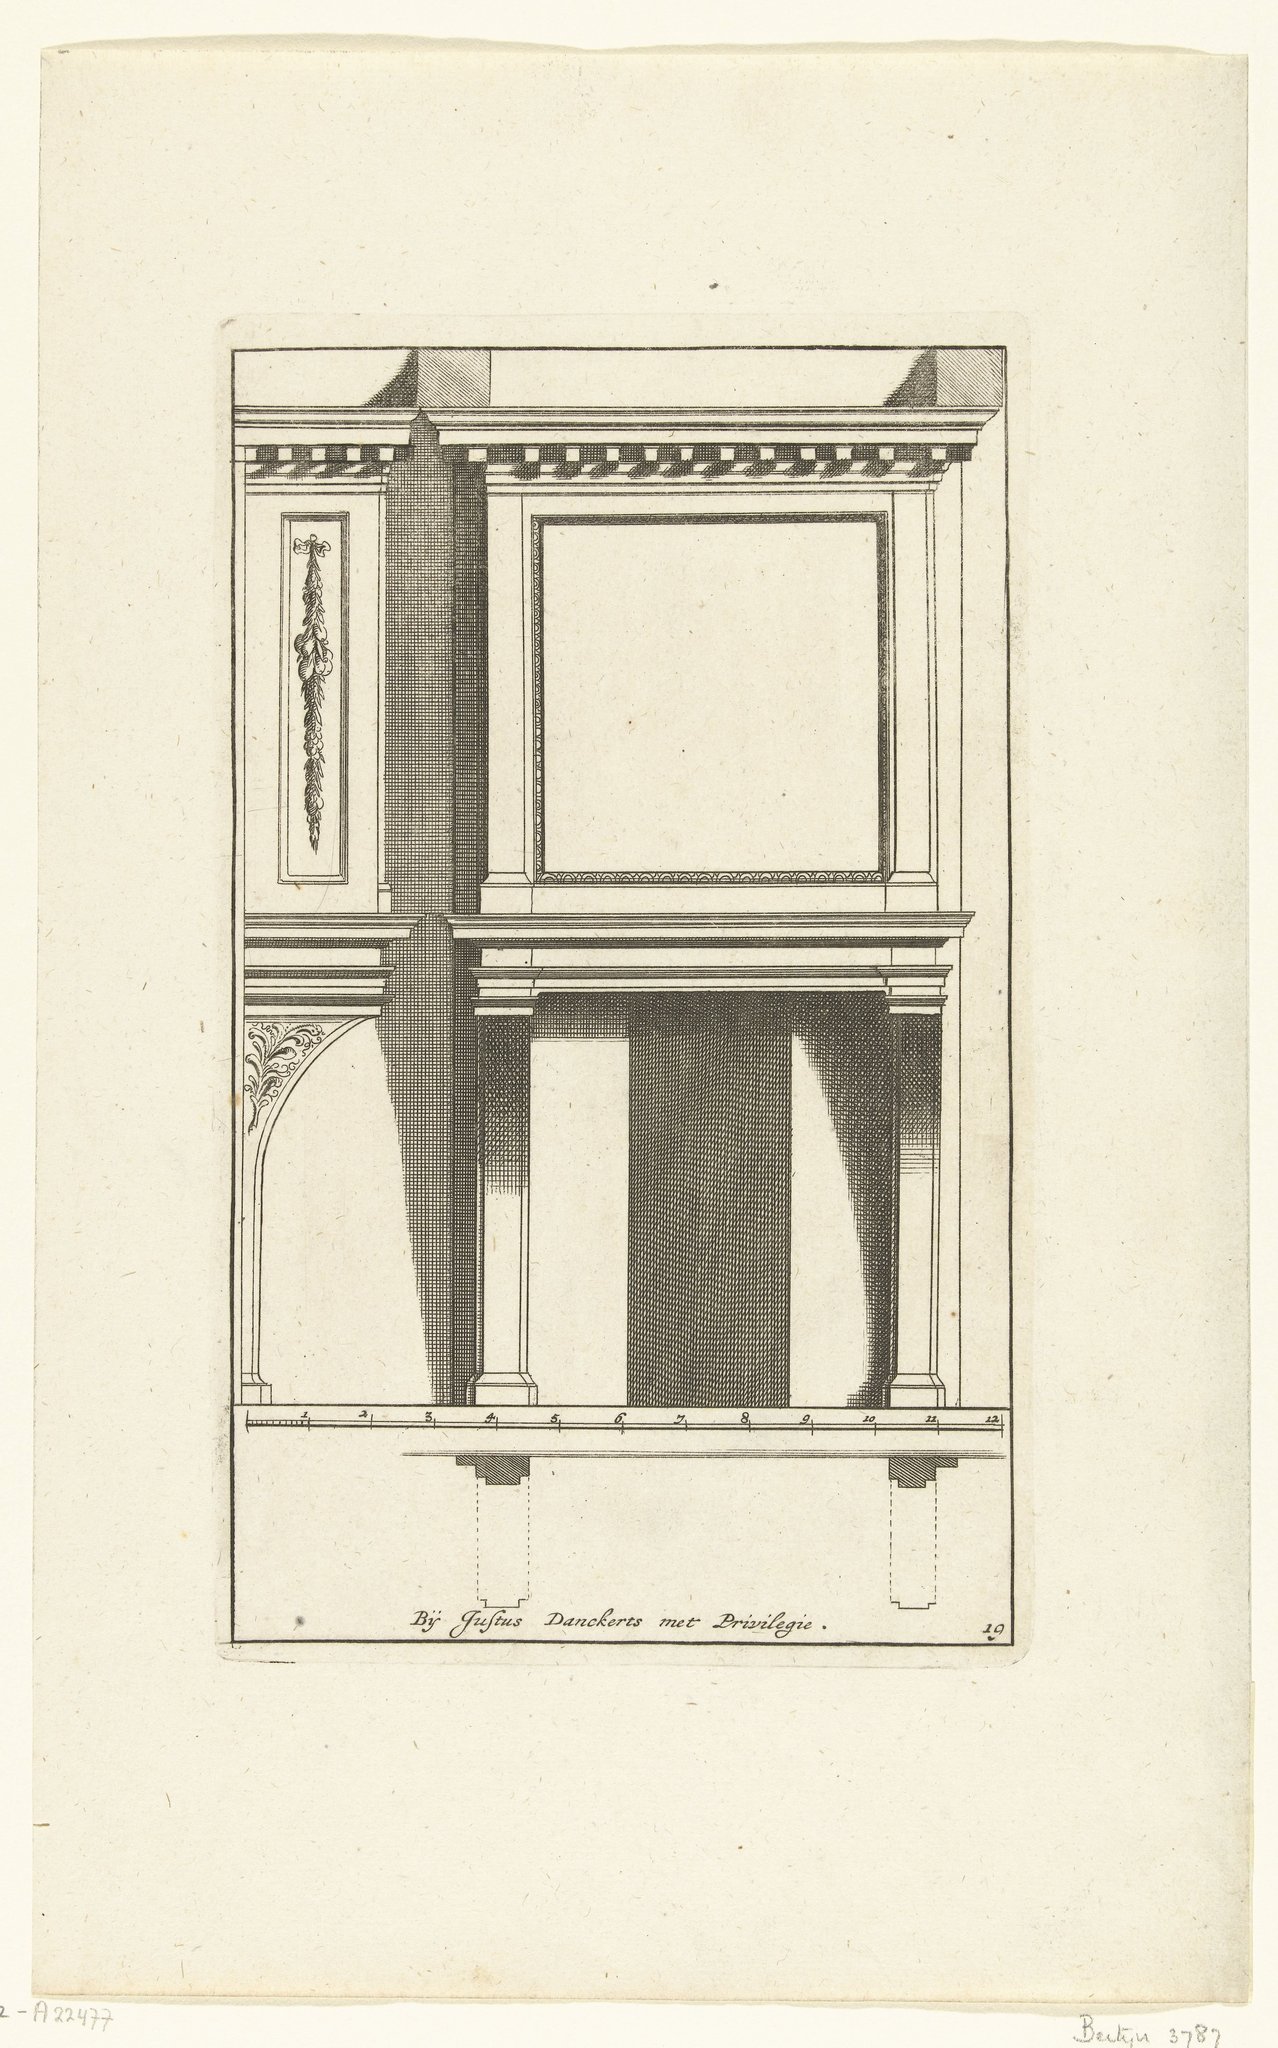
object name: print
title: Onderboezems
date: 1675-1686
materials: paper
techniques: etching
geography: netherlands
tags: chimney-piece, mantelpiece